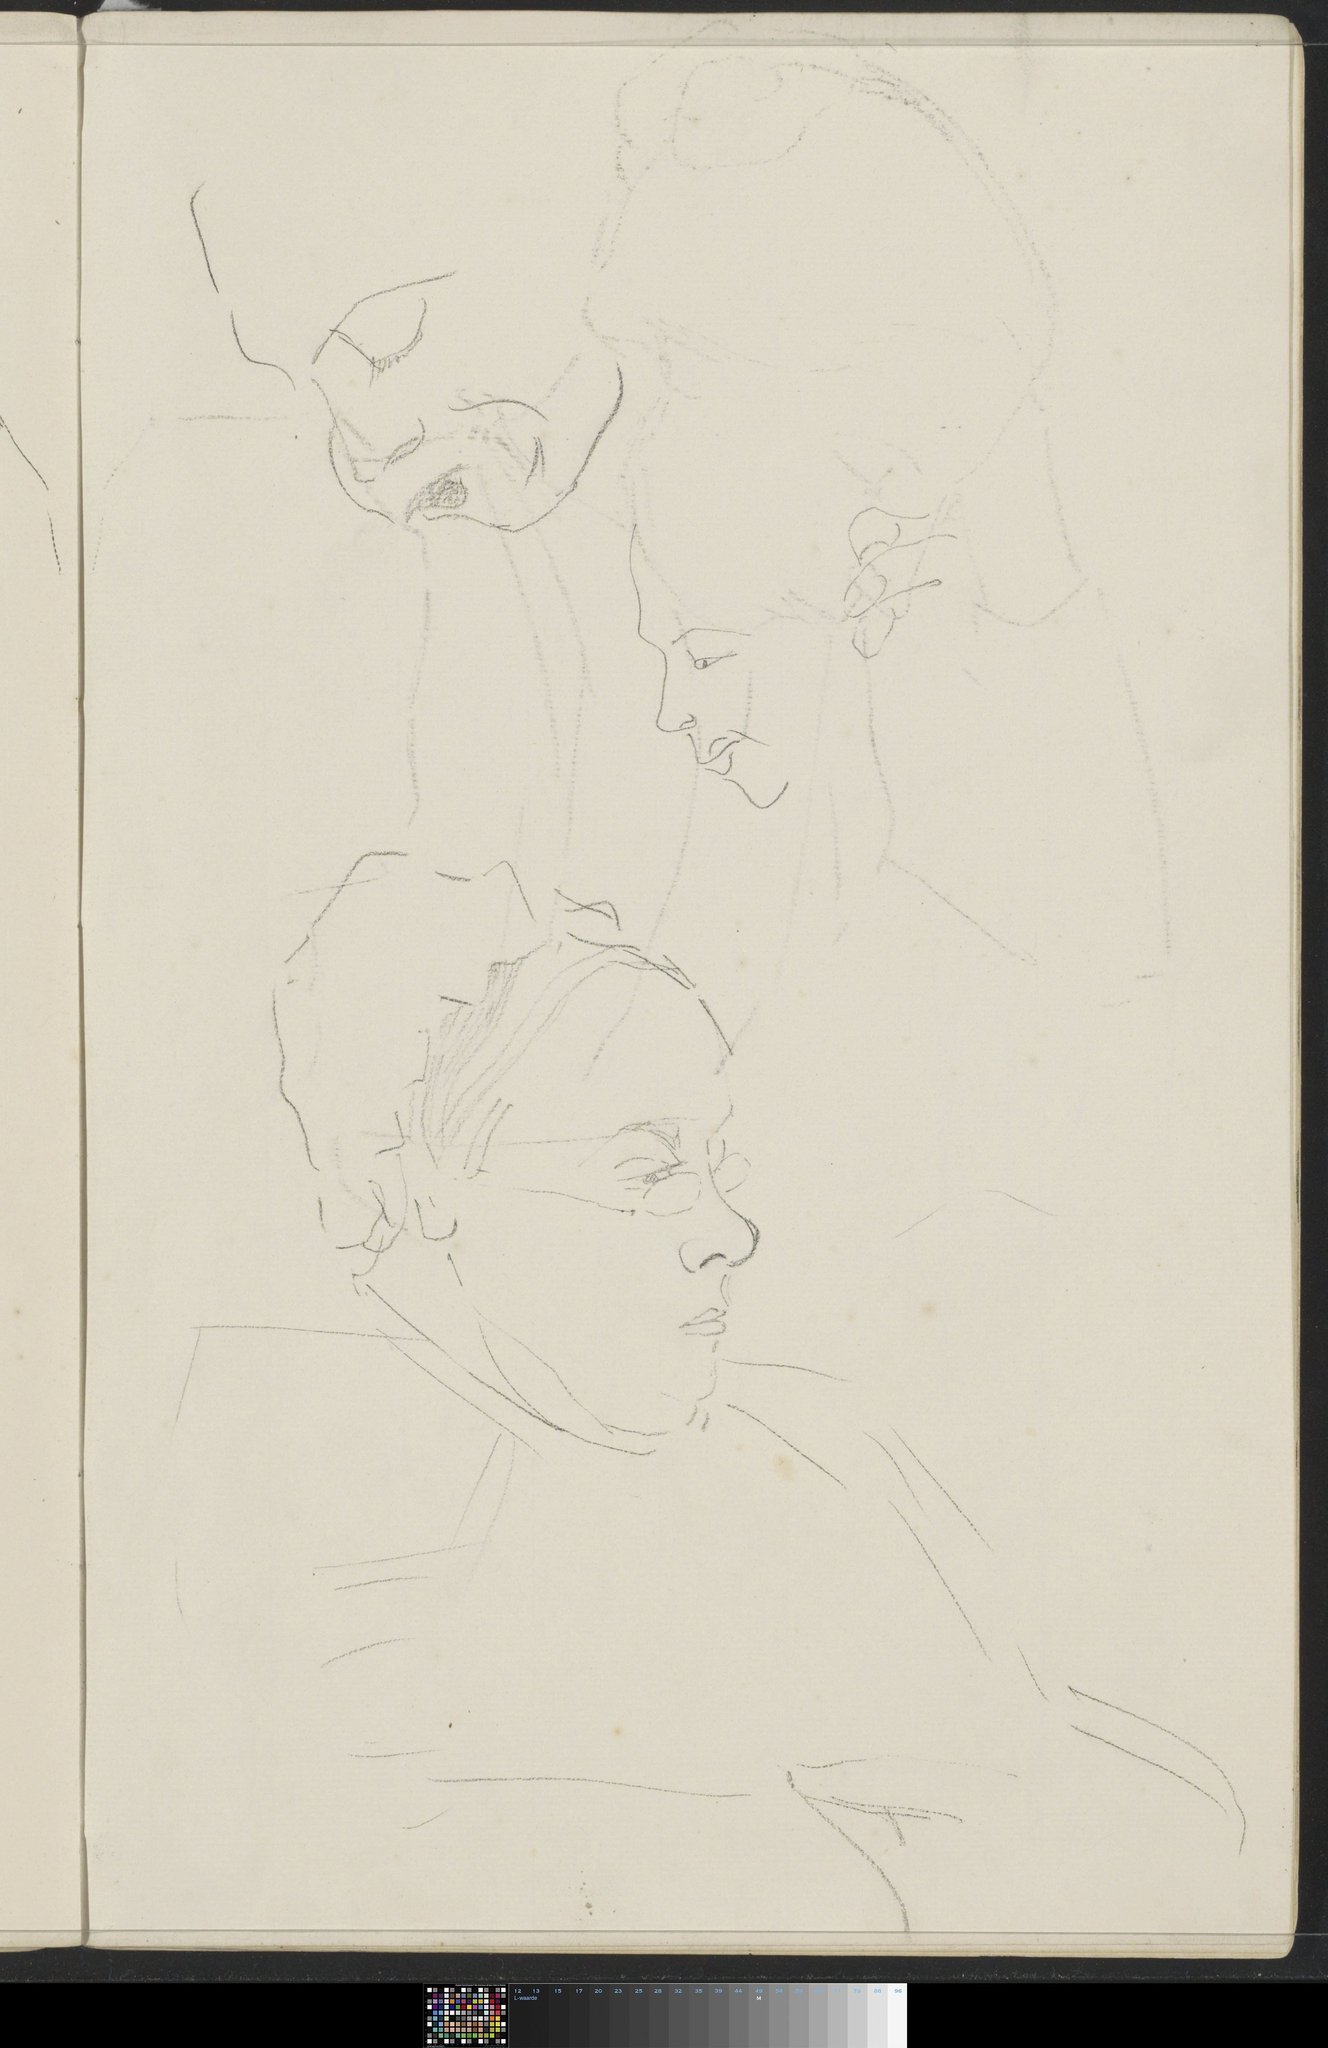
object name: sketchbook leaf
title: Portret van een oudere vrouw met een bril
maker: carel adolph lion cachet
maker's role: draughtsman, print maker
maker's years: 1864-1945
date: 1897-1898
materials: chalk, paper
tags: eyeglasses, spectacles, head (human) - aa - female human figure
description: Tevens twee studies van gezichten. Blad 21 recto uit een schetsboek met 29 bladen.